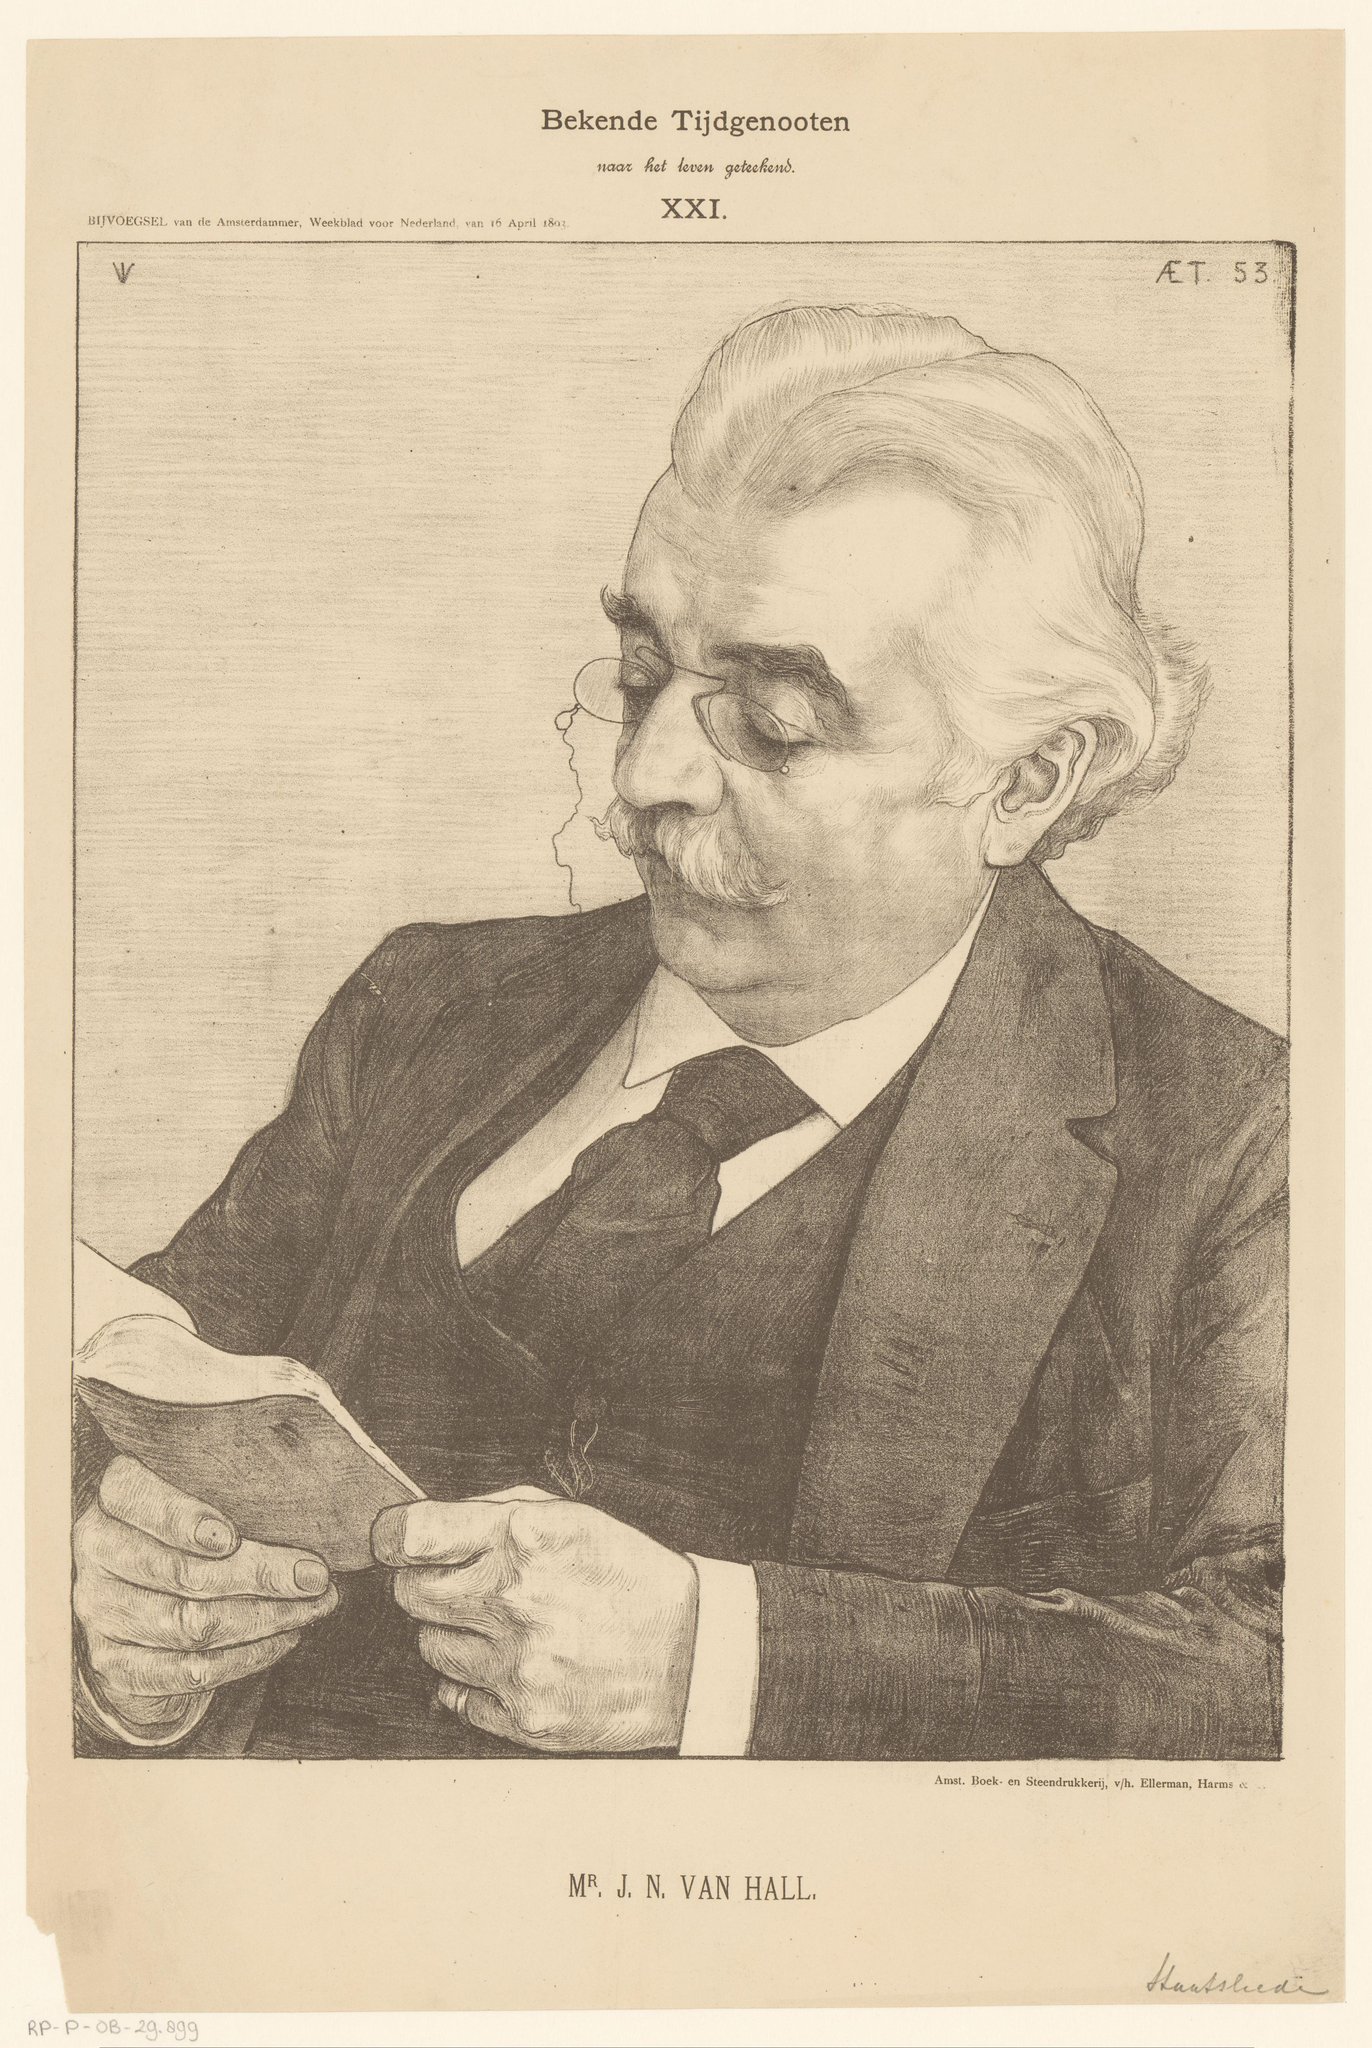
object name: print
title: Mr J.N. van Hall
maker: jan veth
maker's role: designer, draughtsman, painter, print maker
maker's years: 1864-1925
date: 1893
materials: paper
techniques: lithograph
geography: amsterdam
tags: amsterdam, politician, jacob nicolaas van hall, historical persons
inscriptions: collector's mark: Lugt 2228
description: Deze prent werd uitgegeven als bijvoegsel van De Amsterdammer op 16 april 1893.